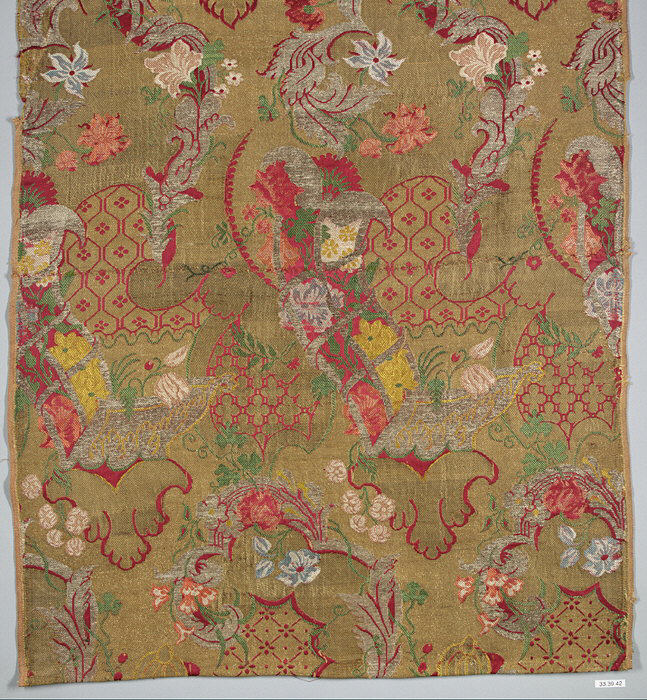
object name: piece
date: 1720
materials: metal thread, silk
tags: flowers,leaves